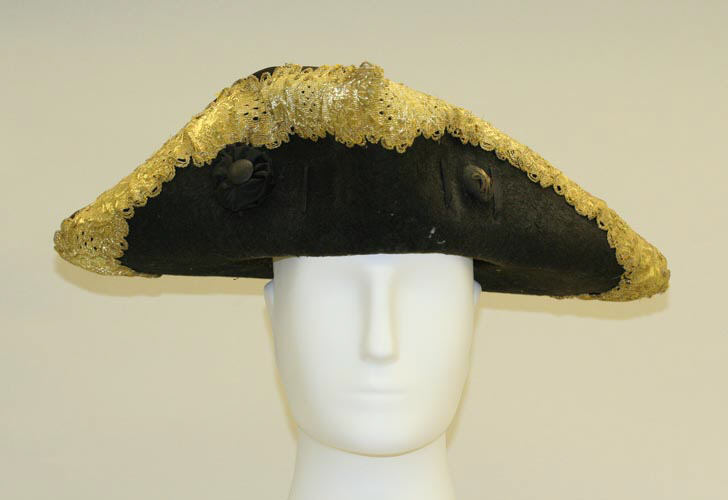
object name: tricorne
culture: french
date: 1750-1775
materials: wool